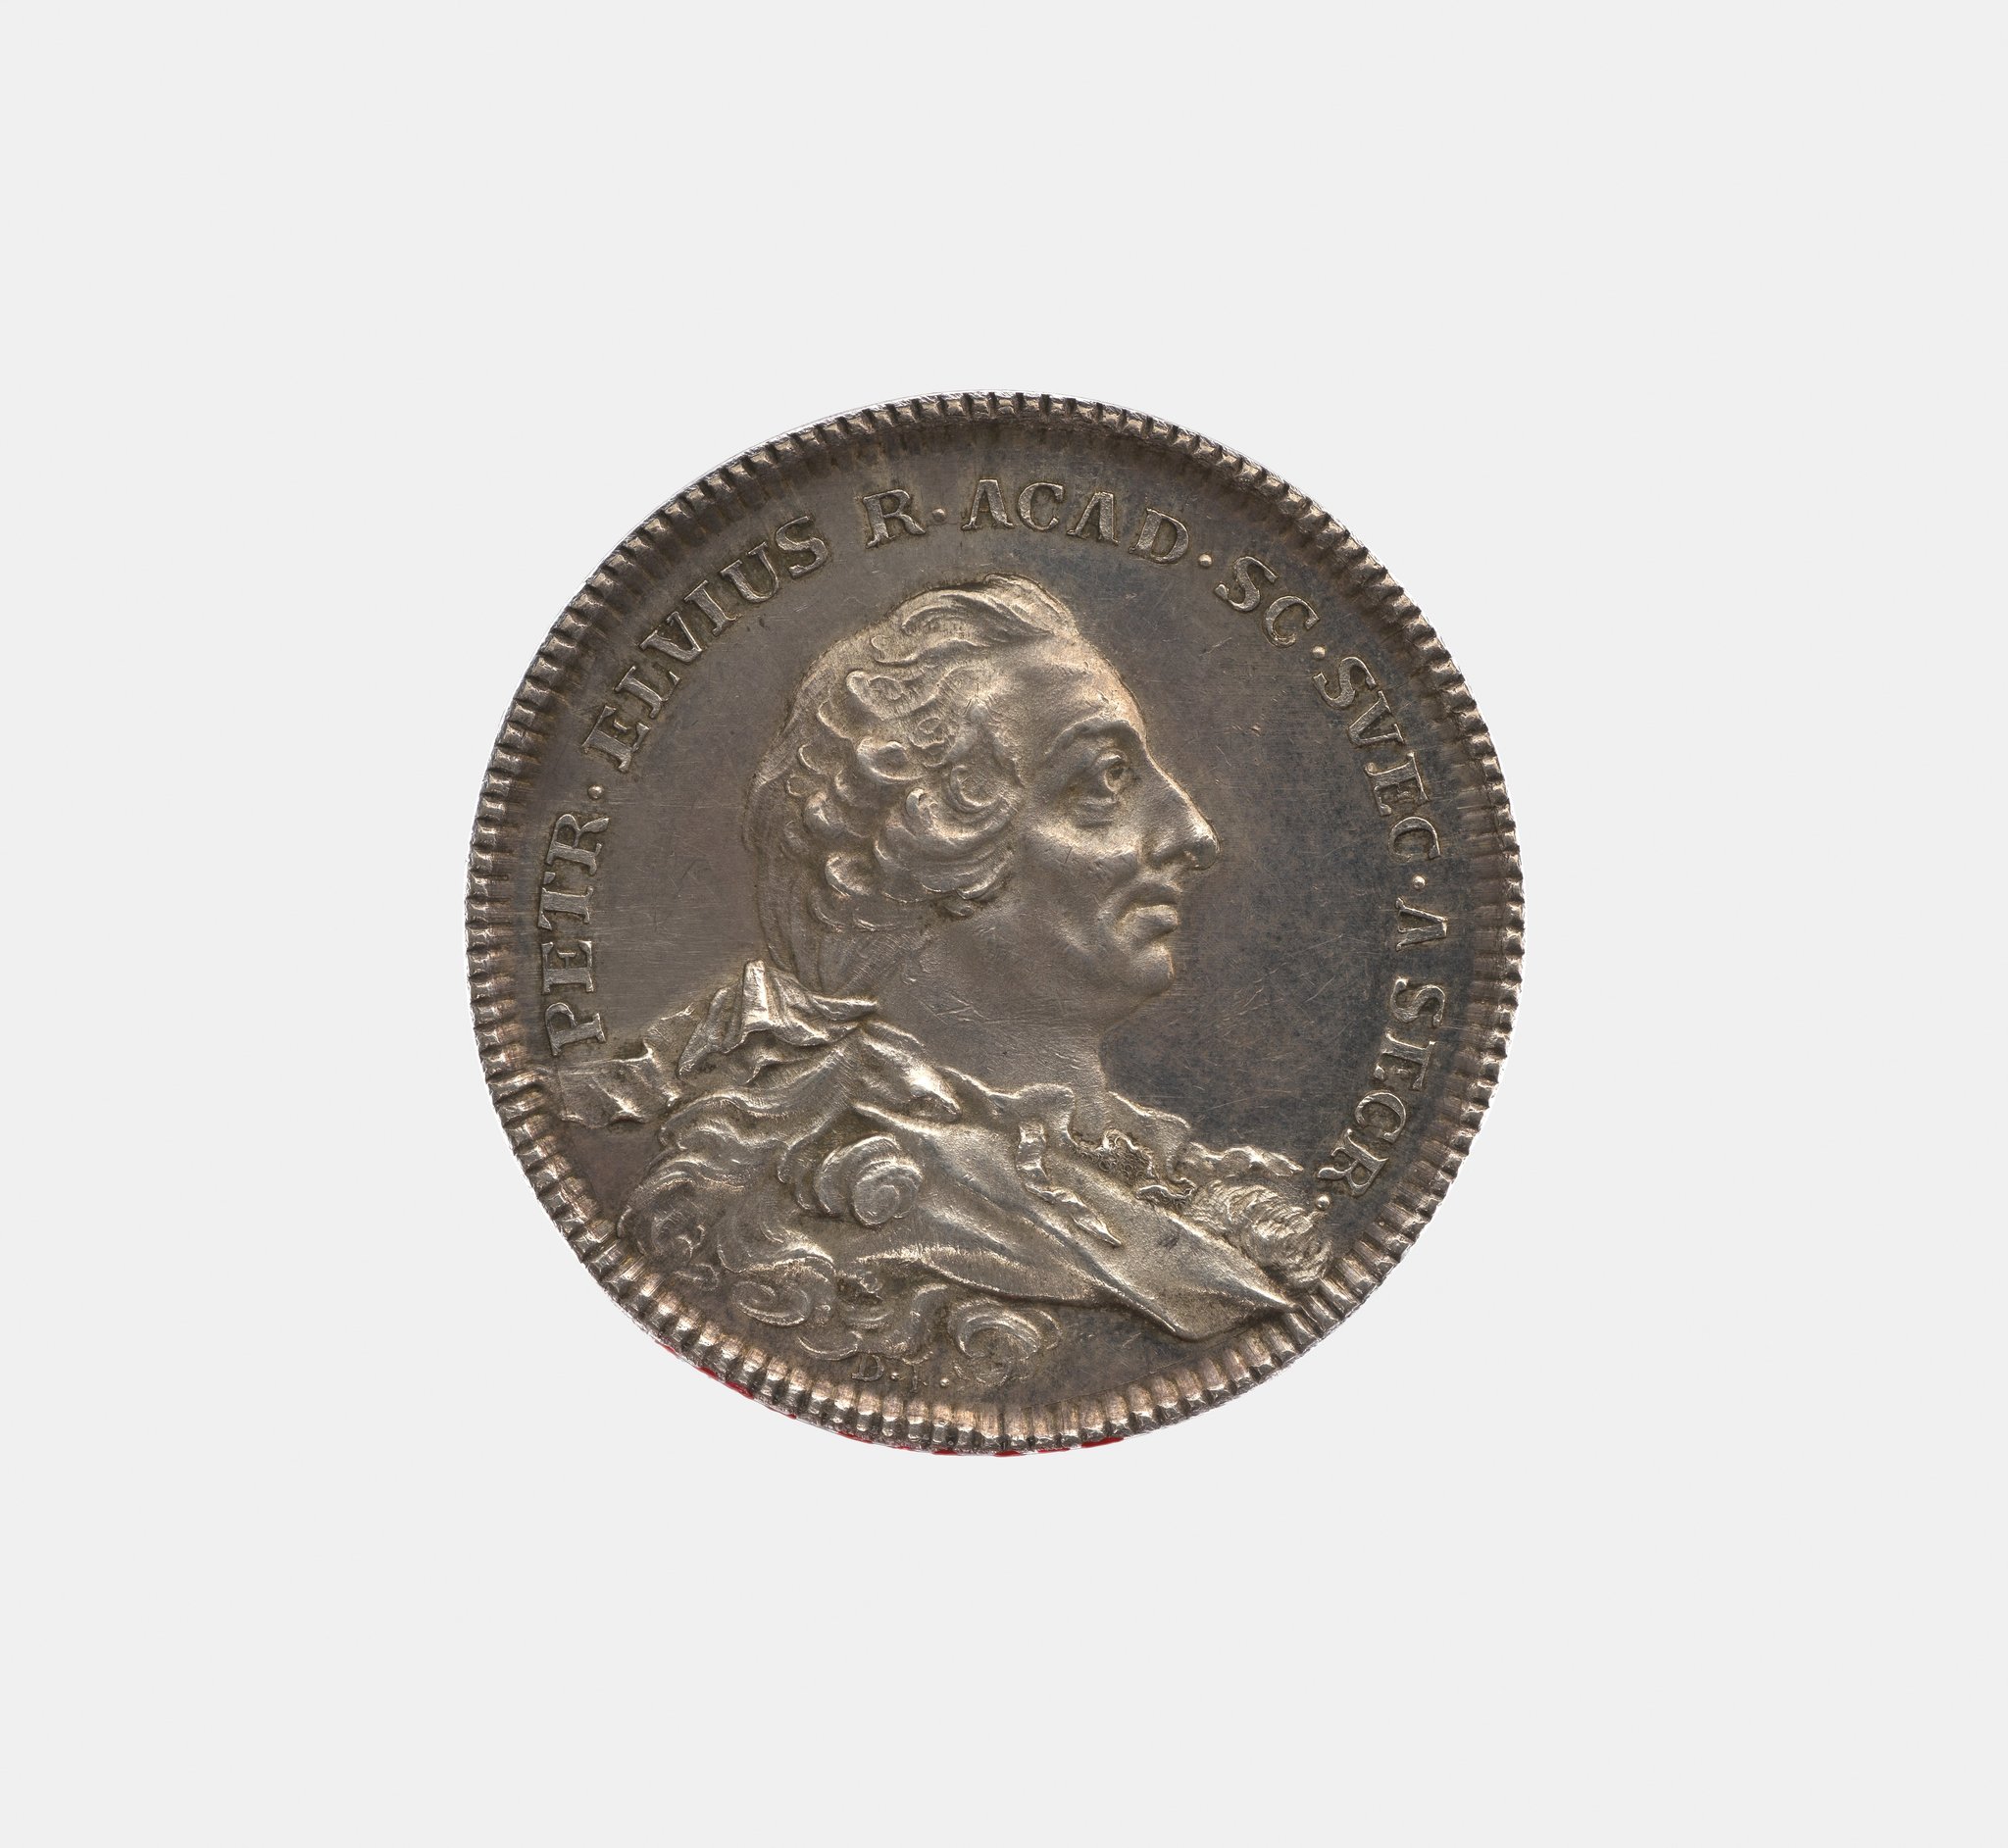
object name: medal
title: Pehr Elvius, Secretary of the Uppsala Royal Scientific Academy (1710–1749)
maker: daniel fehrman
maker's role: artist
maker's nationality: swedish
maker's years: 1710-1780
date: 1749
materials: silver